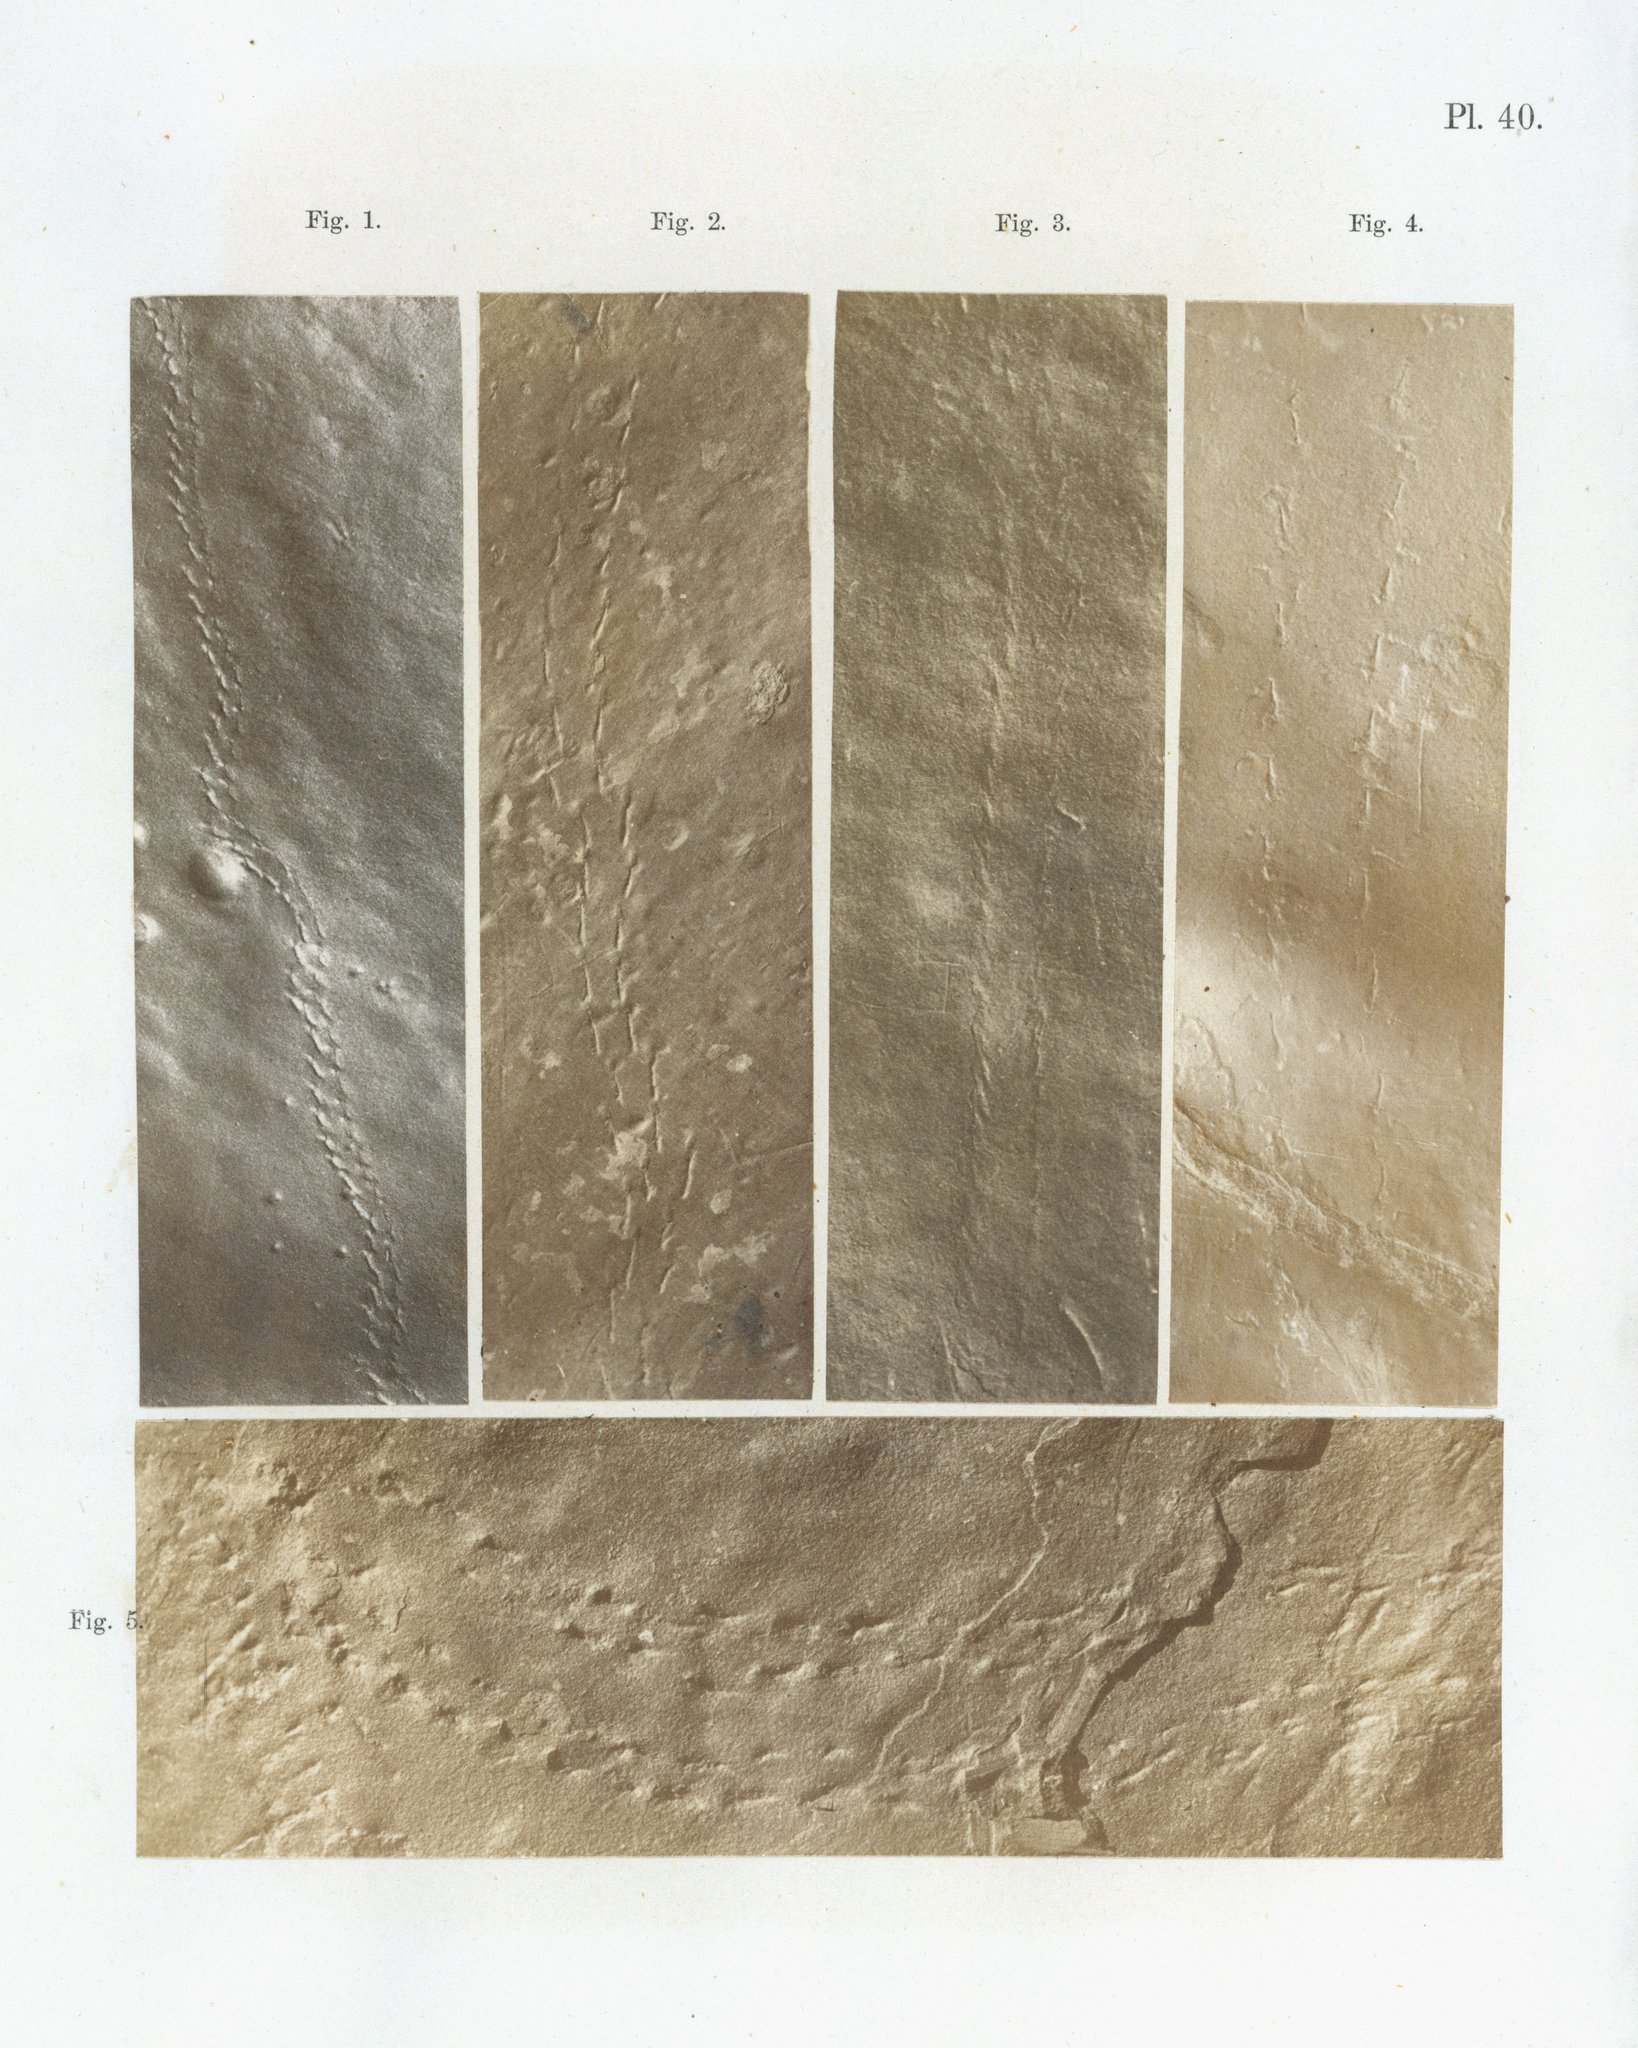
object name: photographically illustrated book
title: Ichnographs from the Sandstone of Connecticut River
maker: james deane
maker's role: artist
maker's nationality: american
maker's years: 1801-1858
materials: photographic print